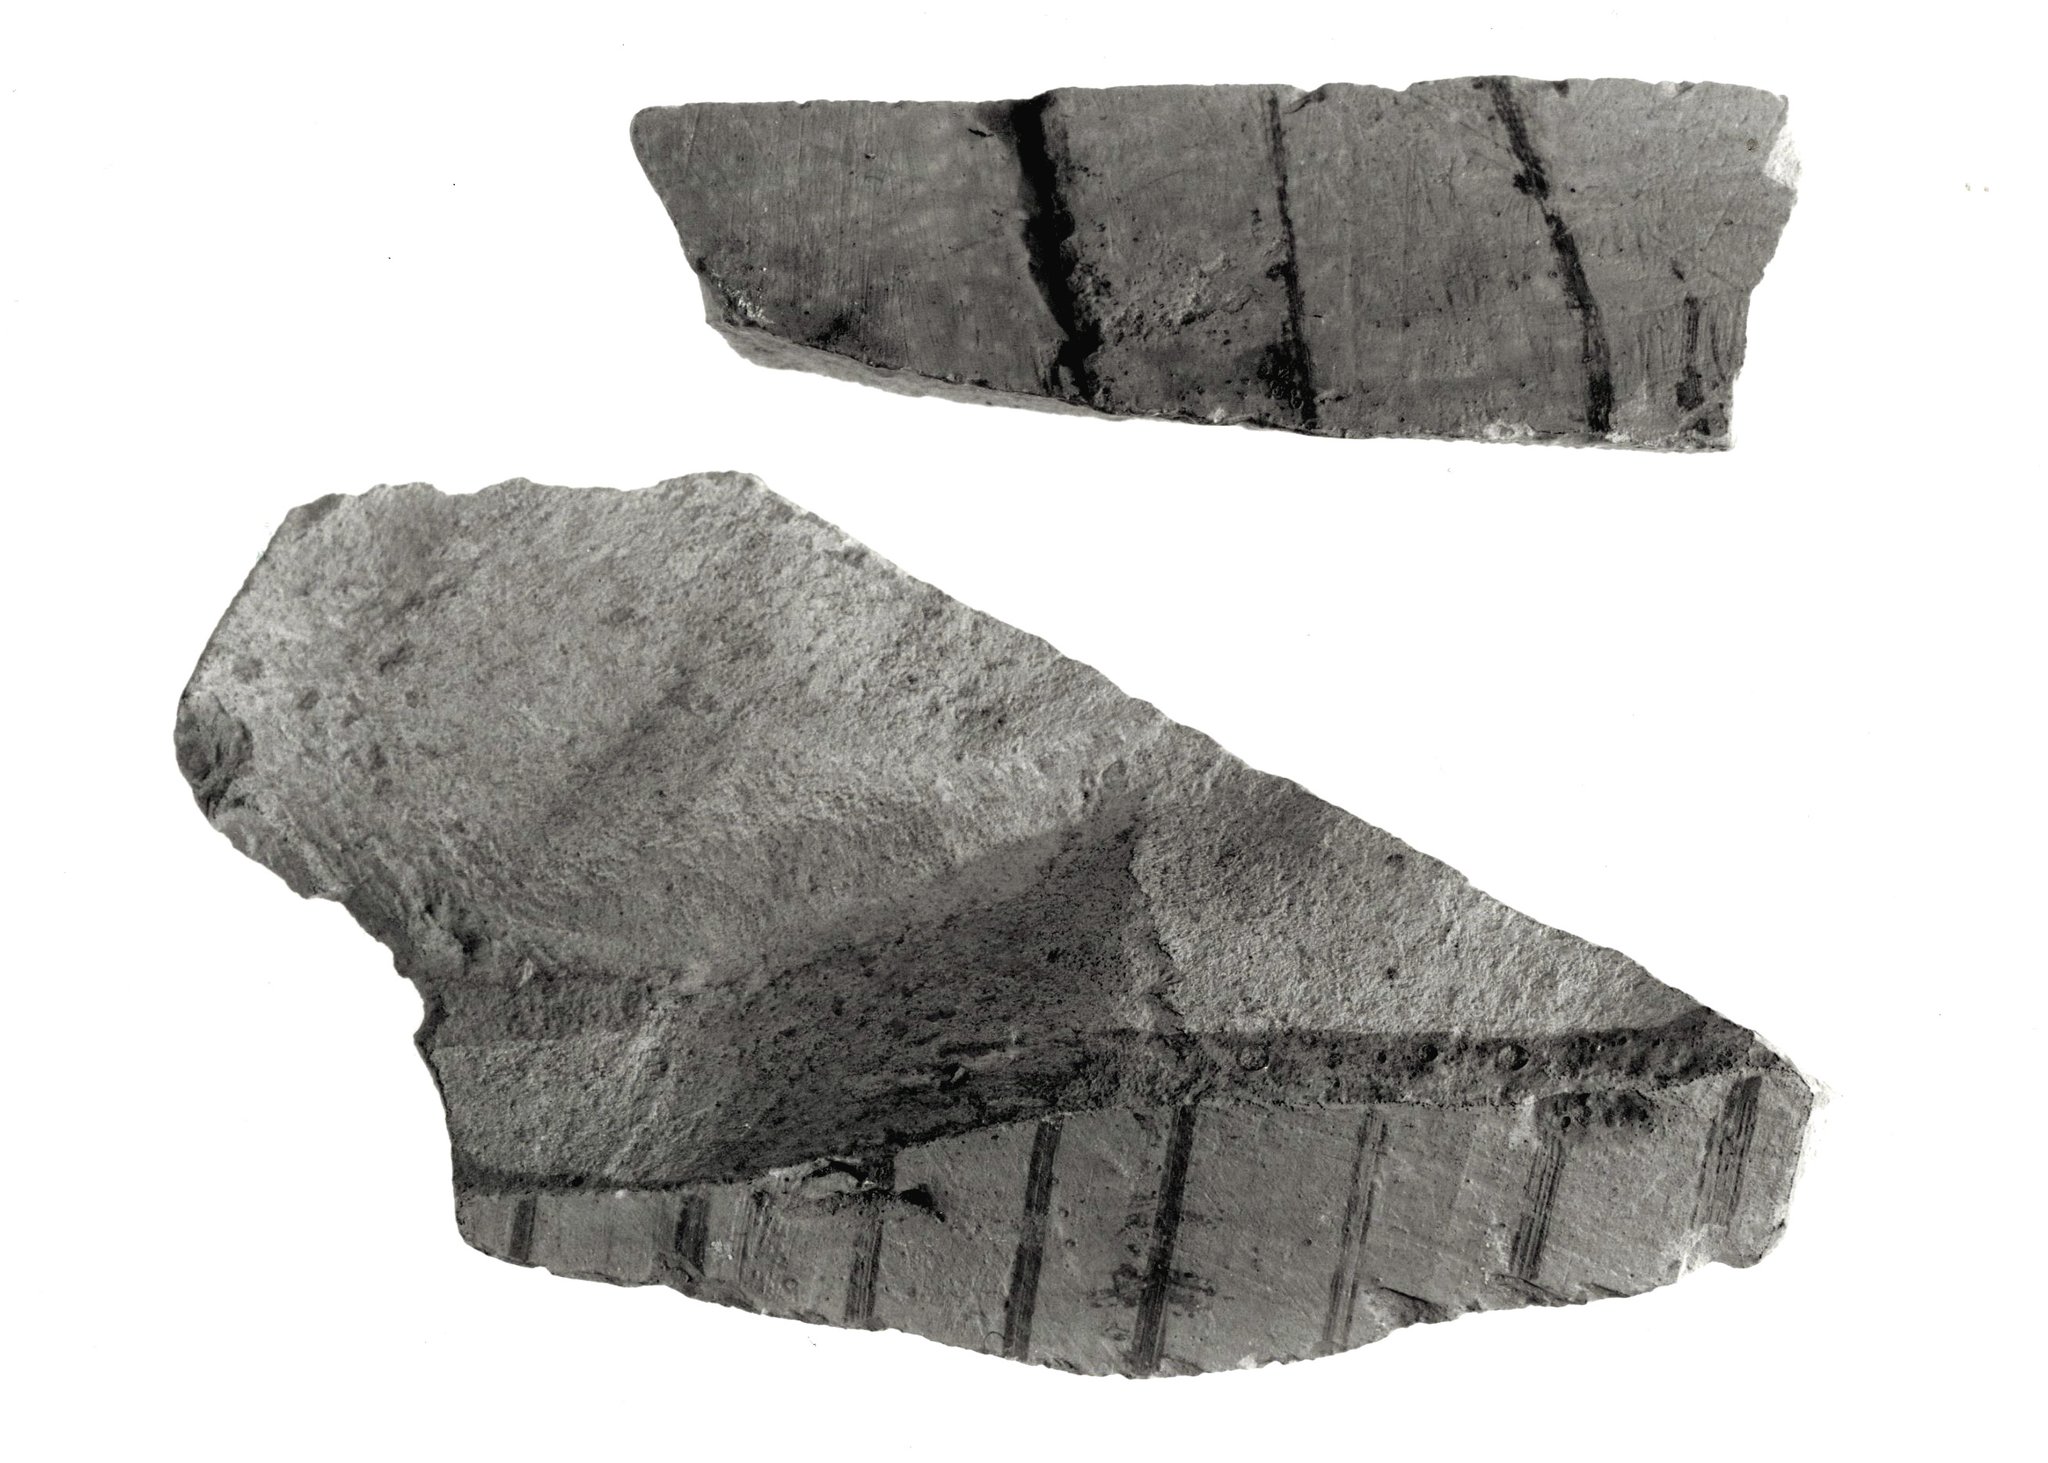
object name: relief, tomb of nespekashuty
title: Drawing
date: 664-610 BCE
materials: limestone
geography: egypt